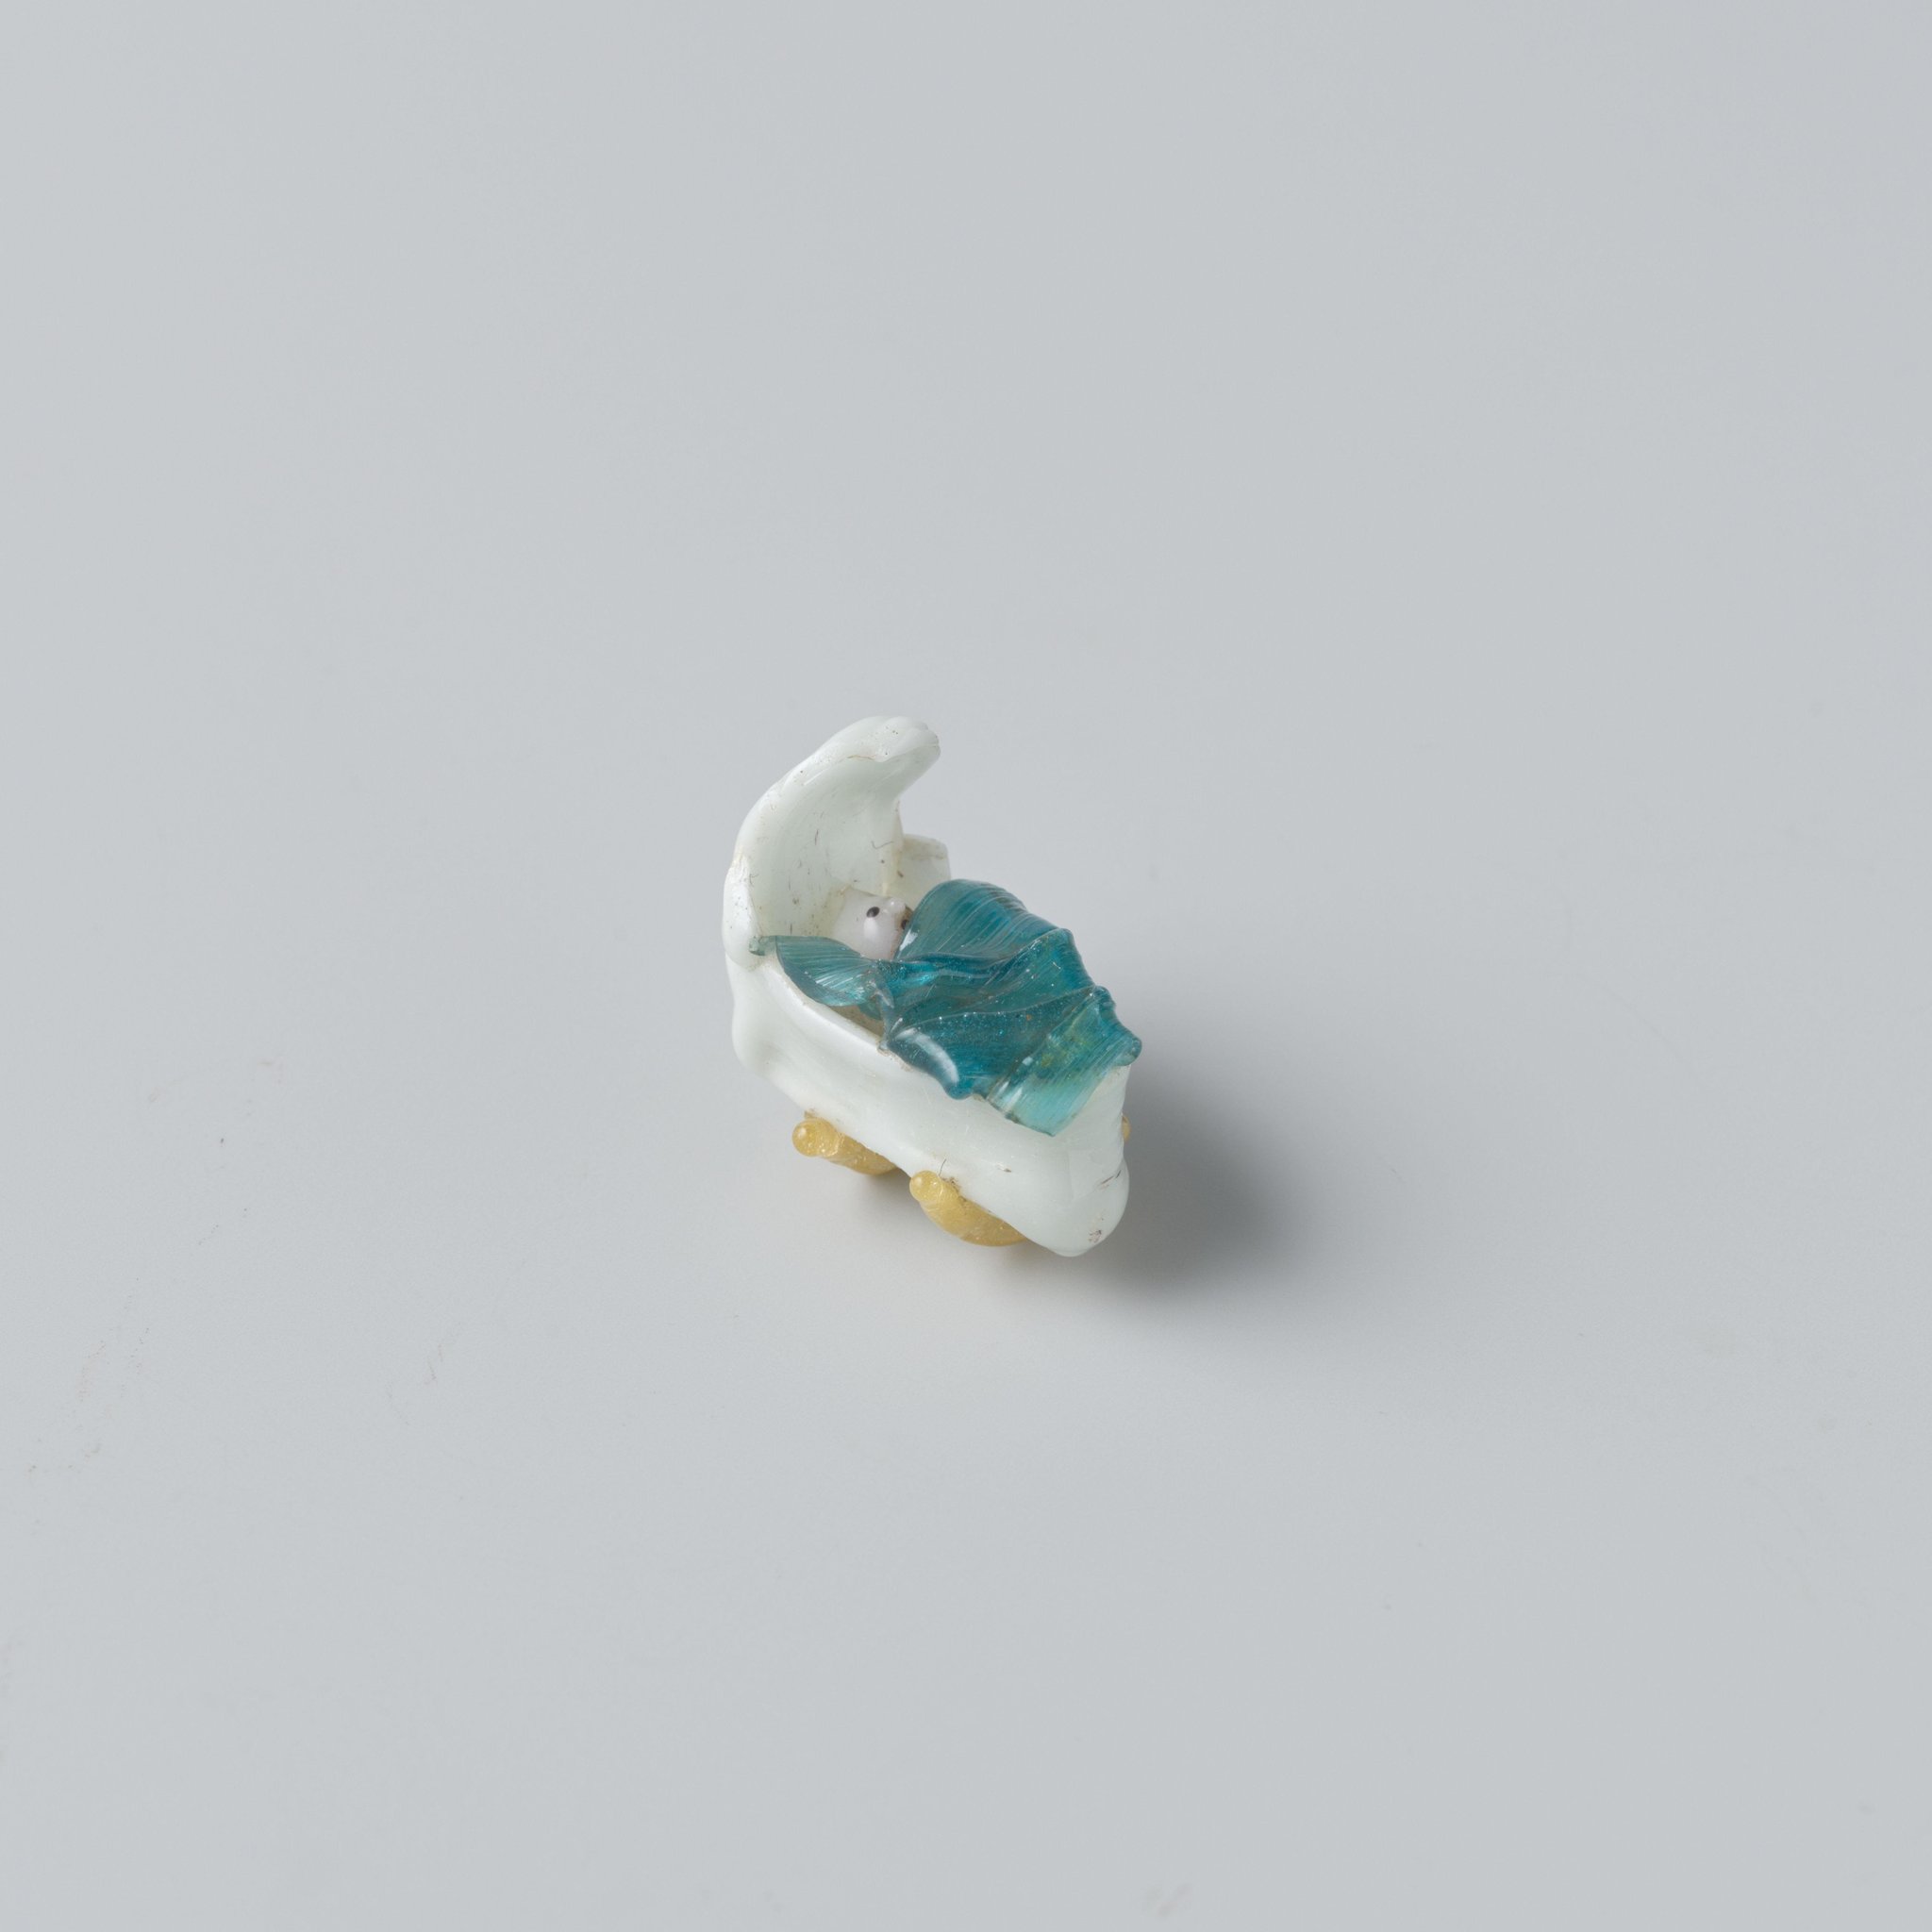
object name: wieg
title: Wieg van opaak wit glas, met gele schenkels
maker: Anonymous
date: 1600-1699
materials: glass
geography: amsterdam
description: Wieg, vervaardigd van opaak wit glas, op gele schenkels en met een helderblauw dekje. In de wieg ligt een wit kind met zwarte ogen.